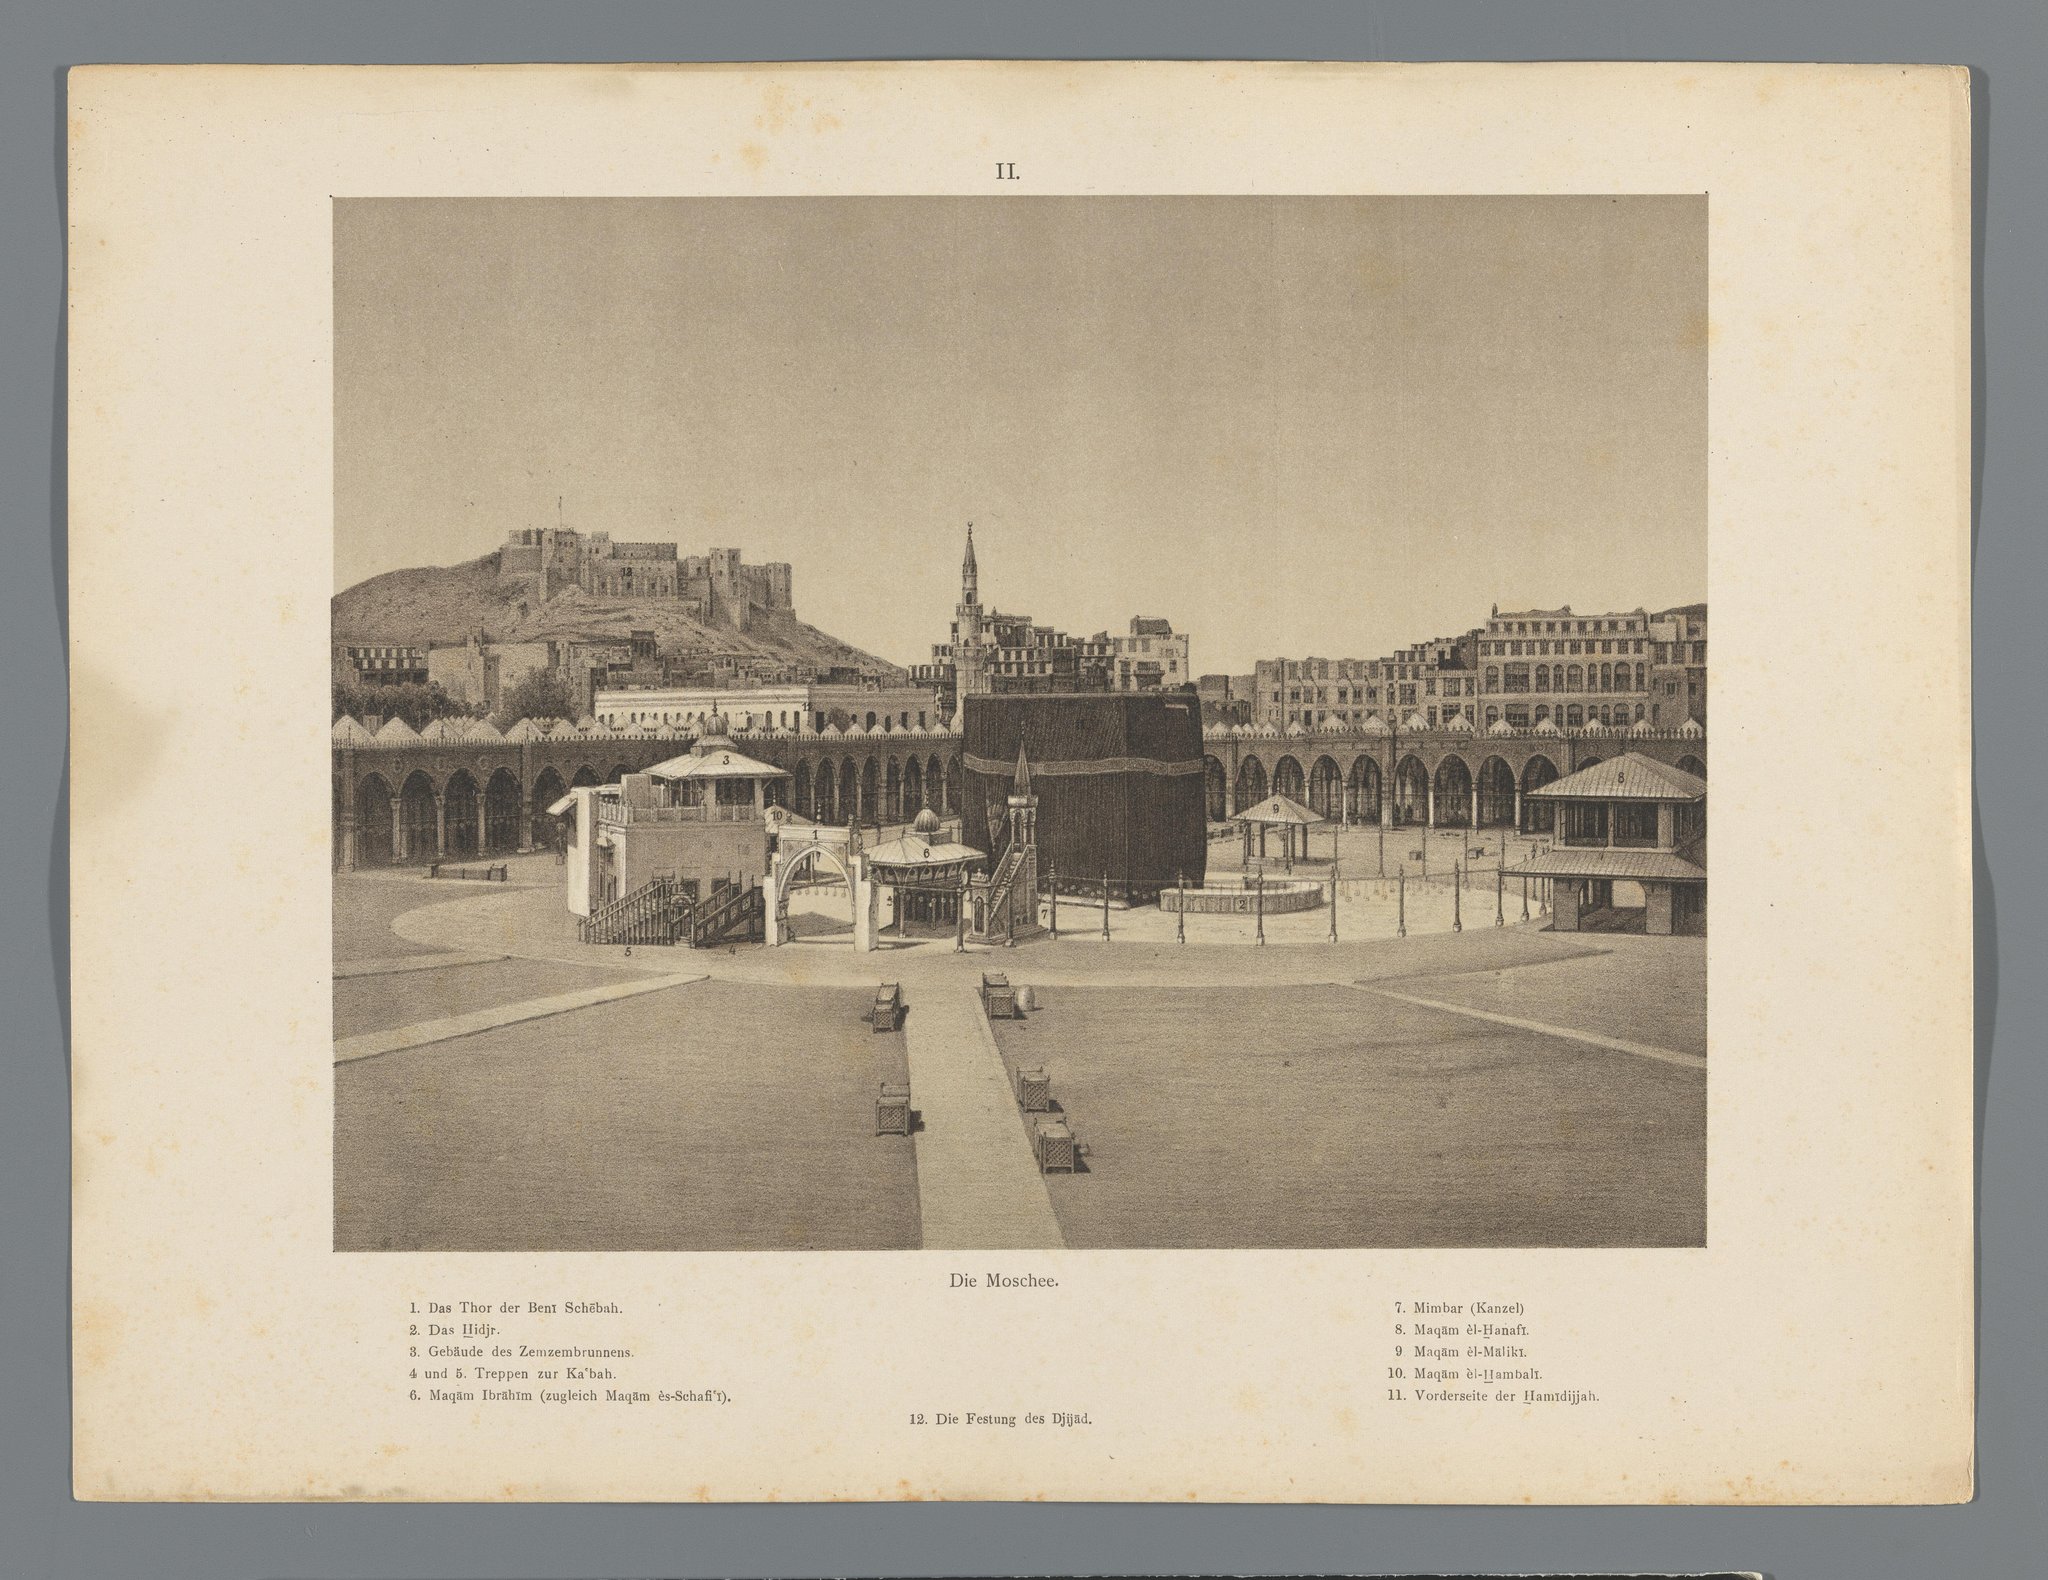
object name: print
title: Gezicht op de Ka'aba te Mekka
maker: Anonymous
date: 1883-1888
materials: paper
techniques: lithograph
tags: temple, shrine ~ islam, mohammedanism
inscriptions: number: ‘II.’